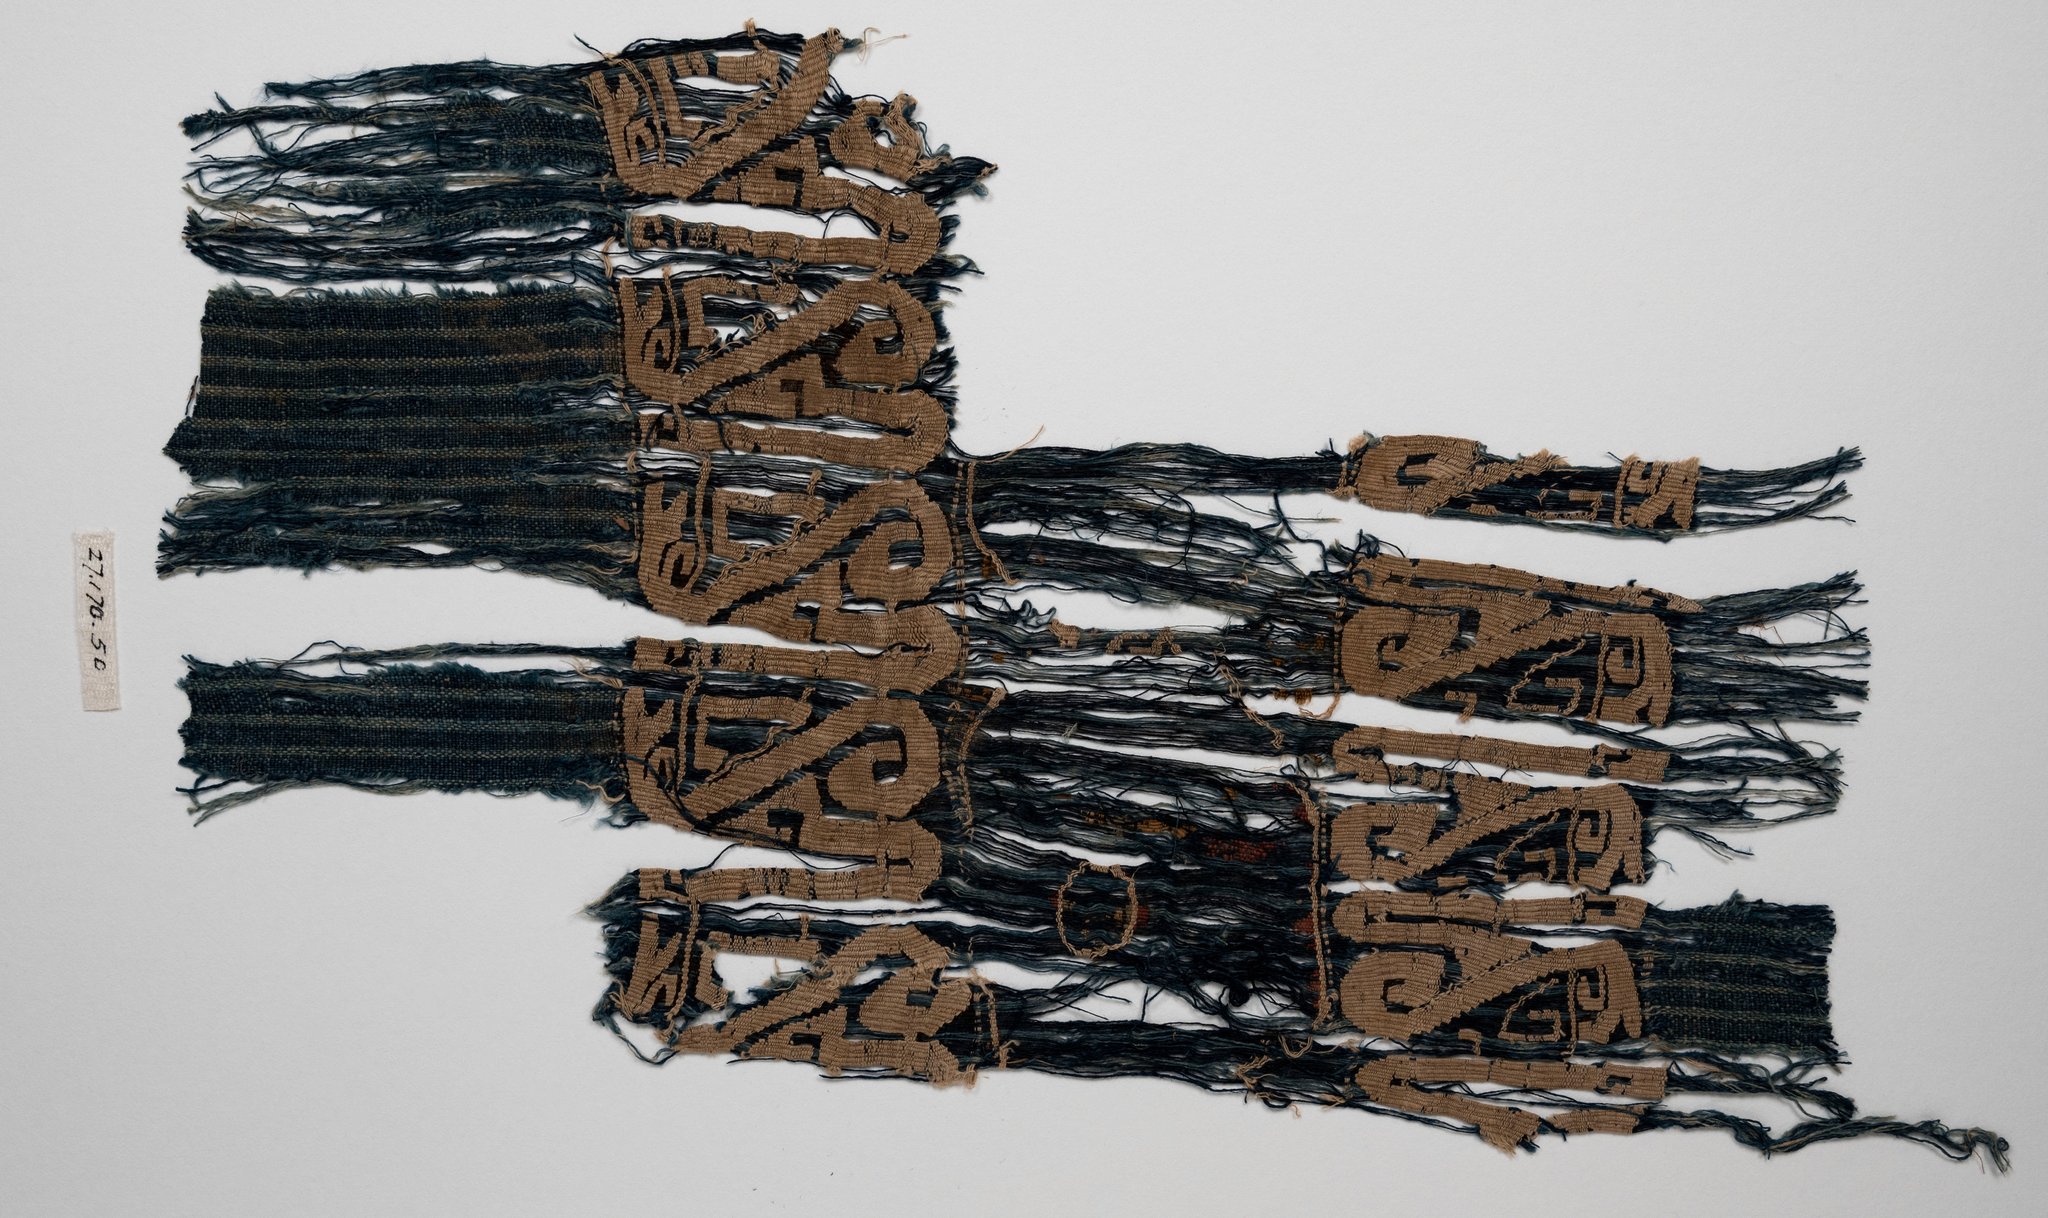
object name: textile fragment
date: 1001-1050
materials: linen, silk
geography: egypt